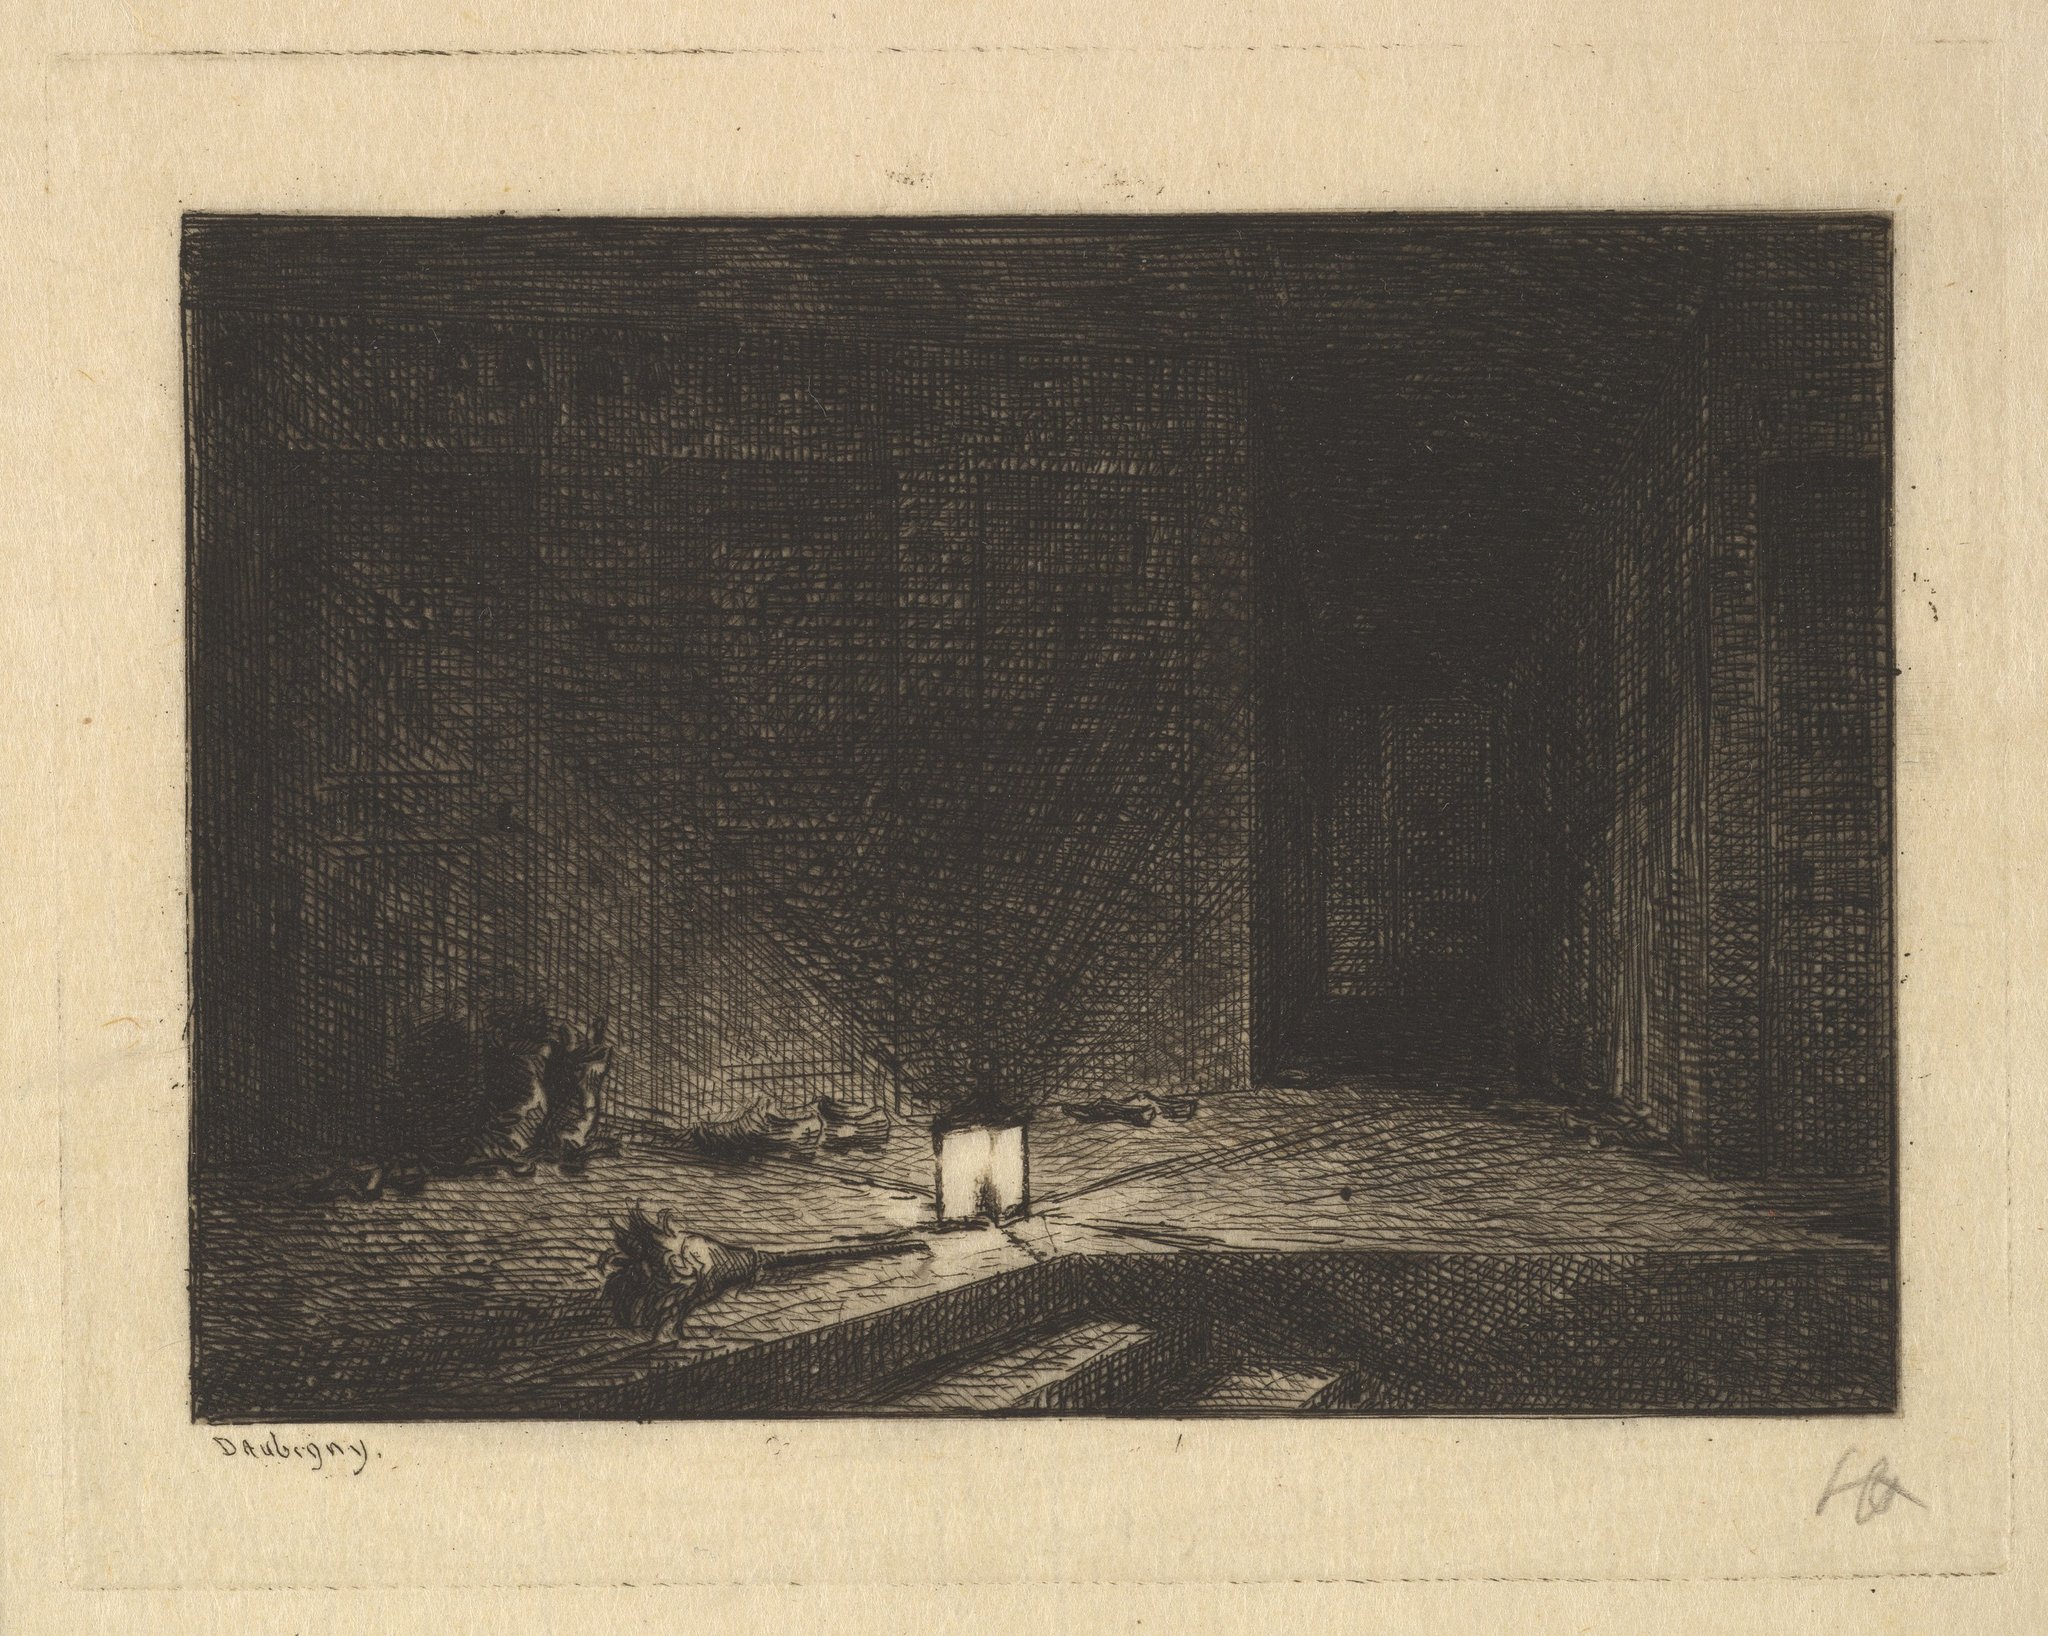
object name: print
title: Interior of an Inn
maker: charles-françois daubigny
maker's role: artist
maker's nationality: french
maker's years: 1817-1878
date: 1861-1862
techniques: etching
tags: interiors,lamps